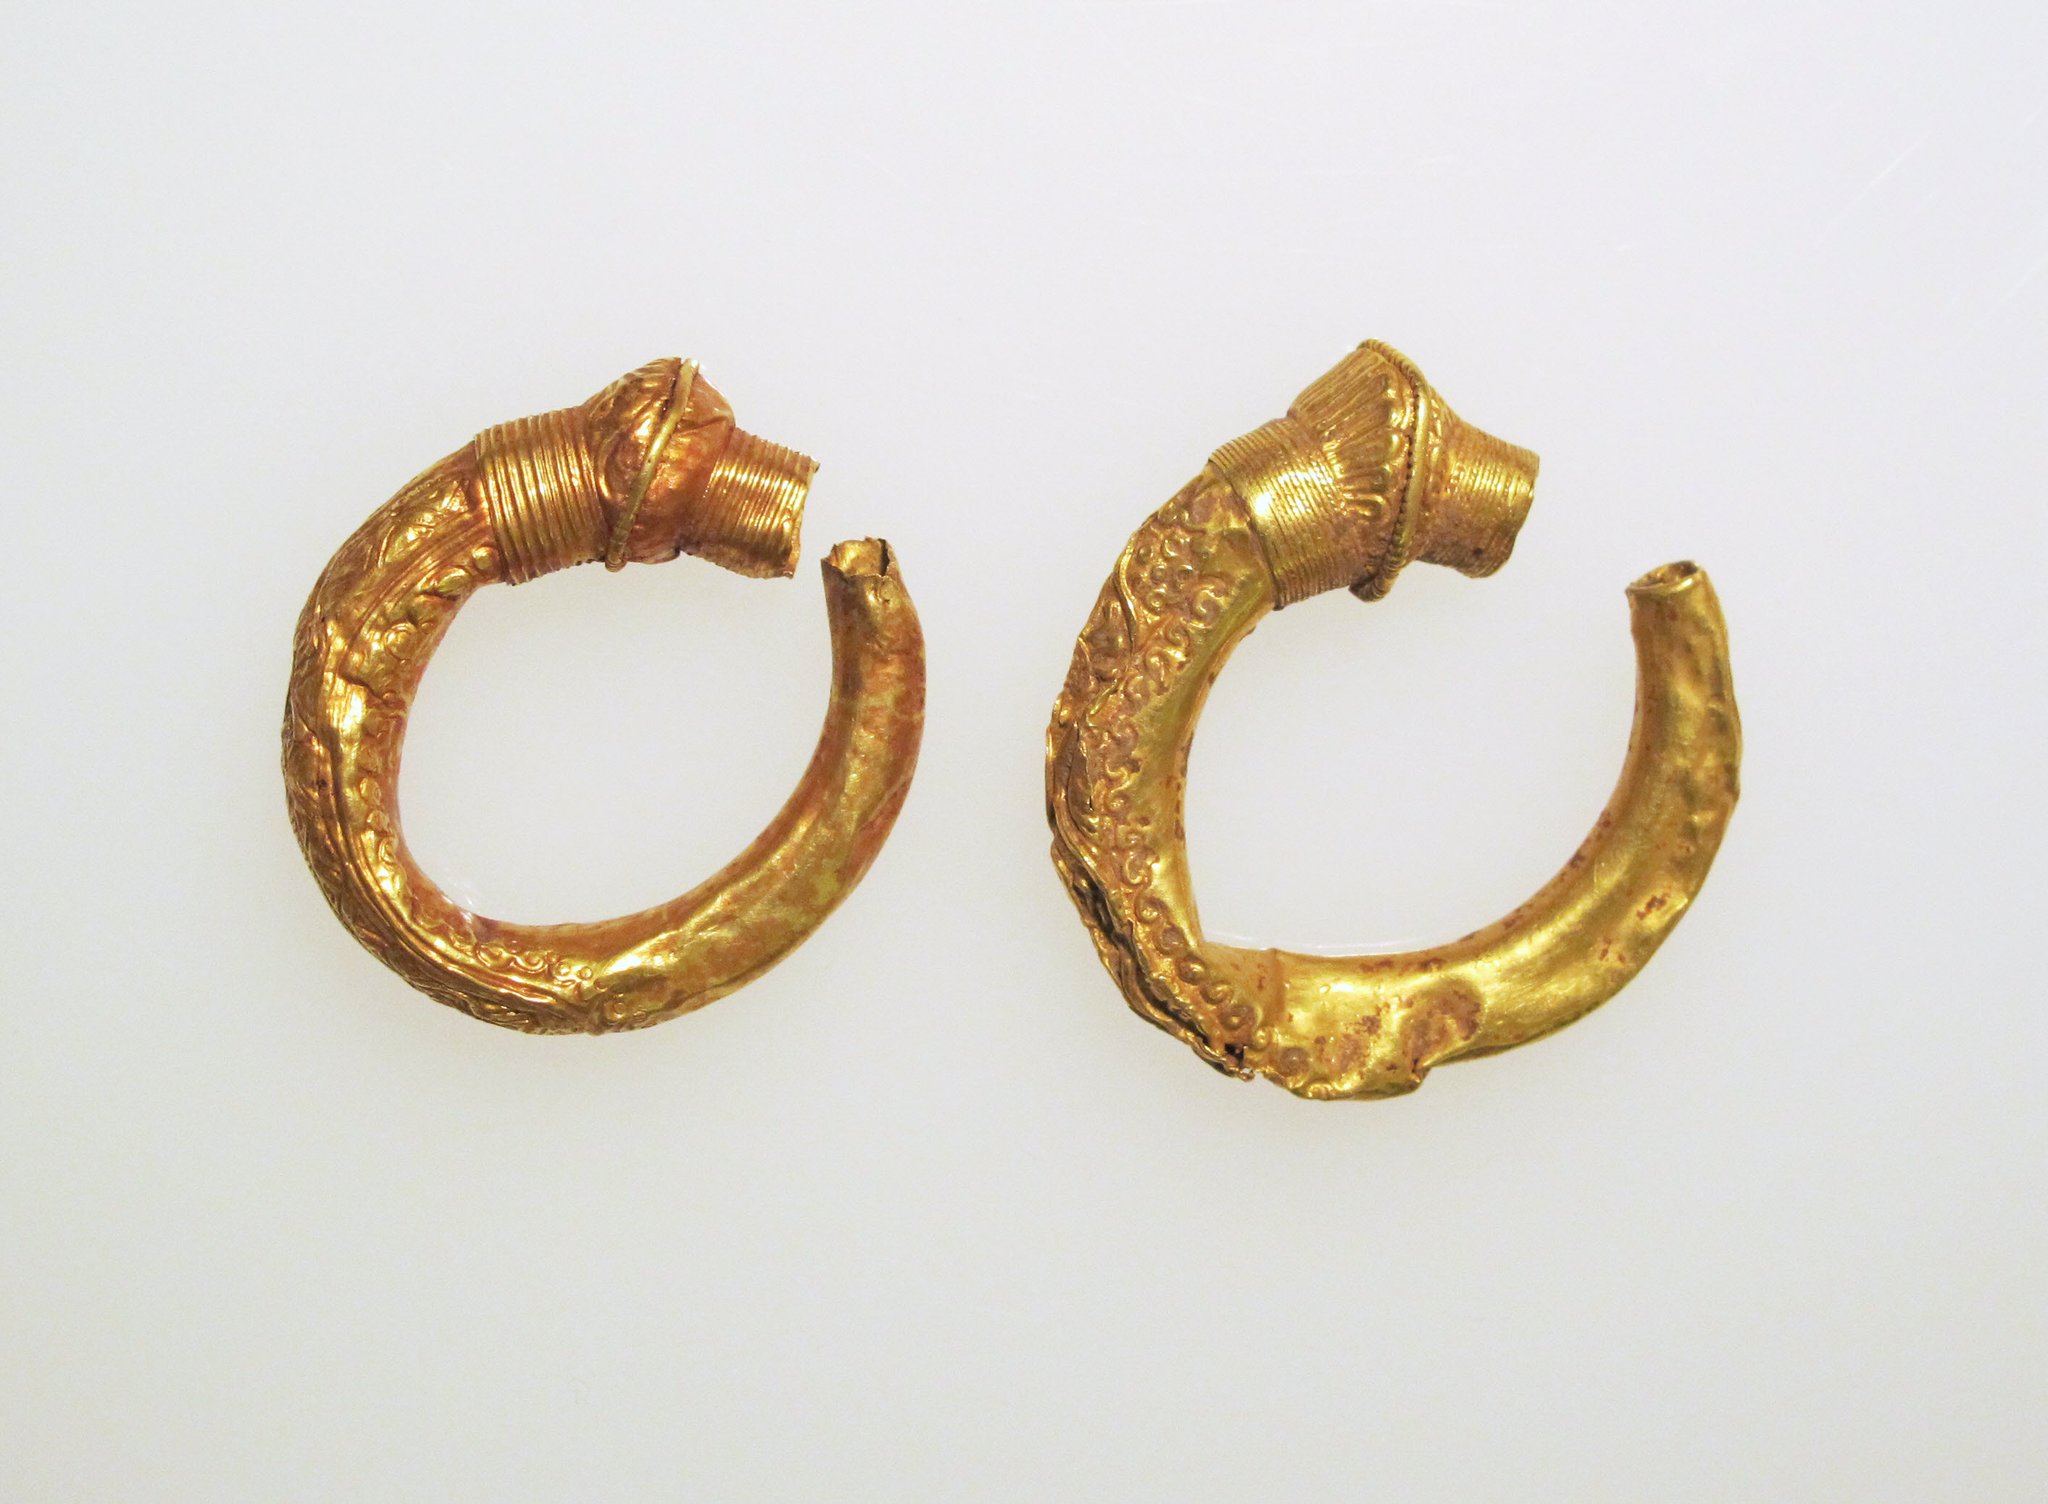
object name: earring, trumpet shaped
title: Earring, trumpet-shaped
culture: etruscan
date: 500-201 BCE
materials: gold